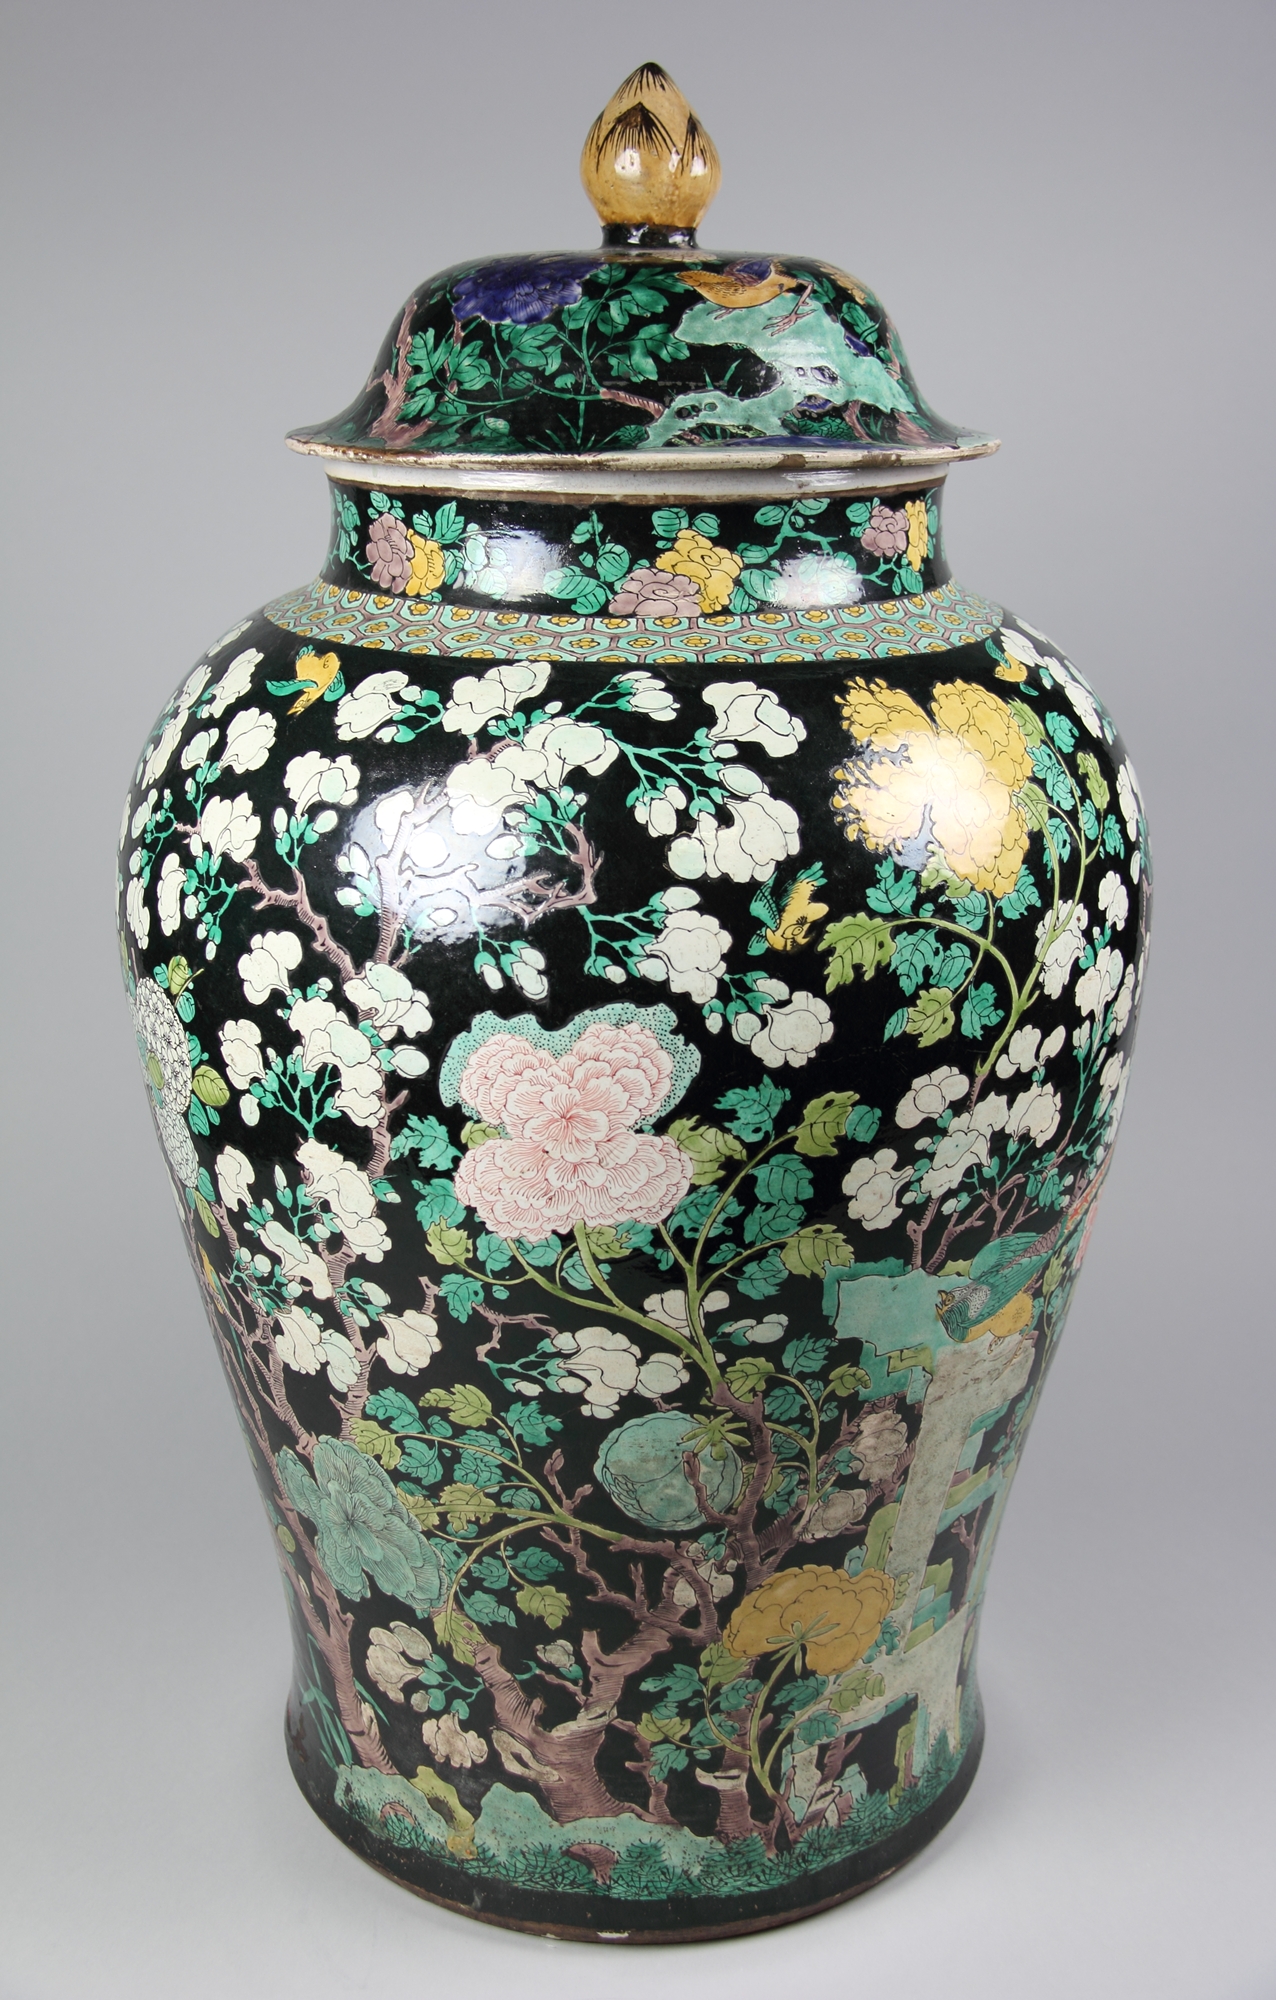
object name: covered jar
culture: chinese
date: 1801-1900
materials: enamel, porcelain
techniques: overglaze, painting, polychrome